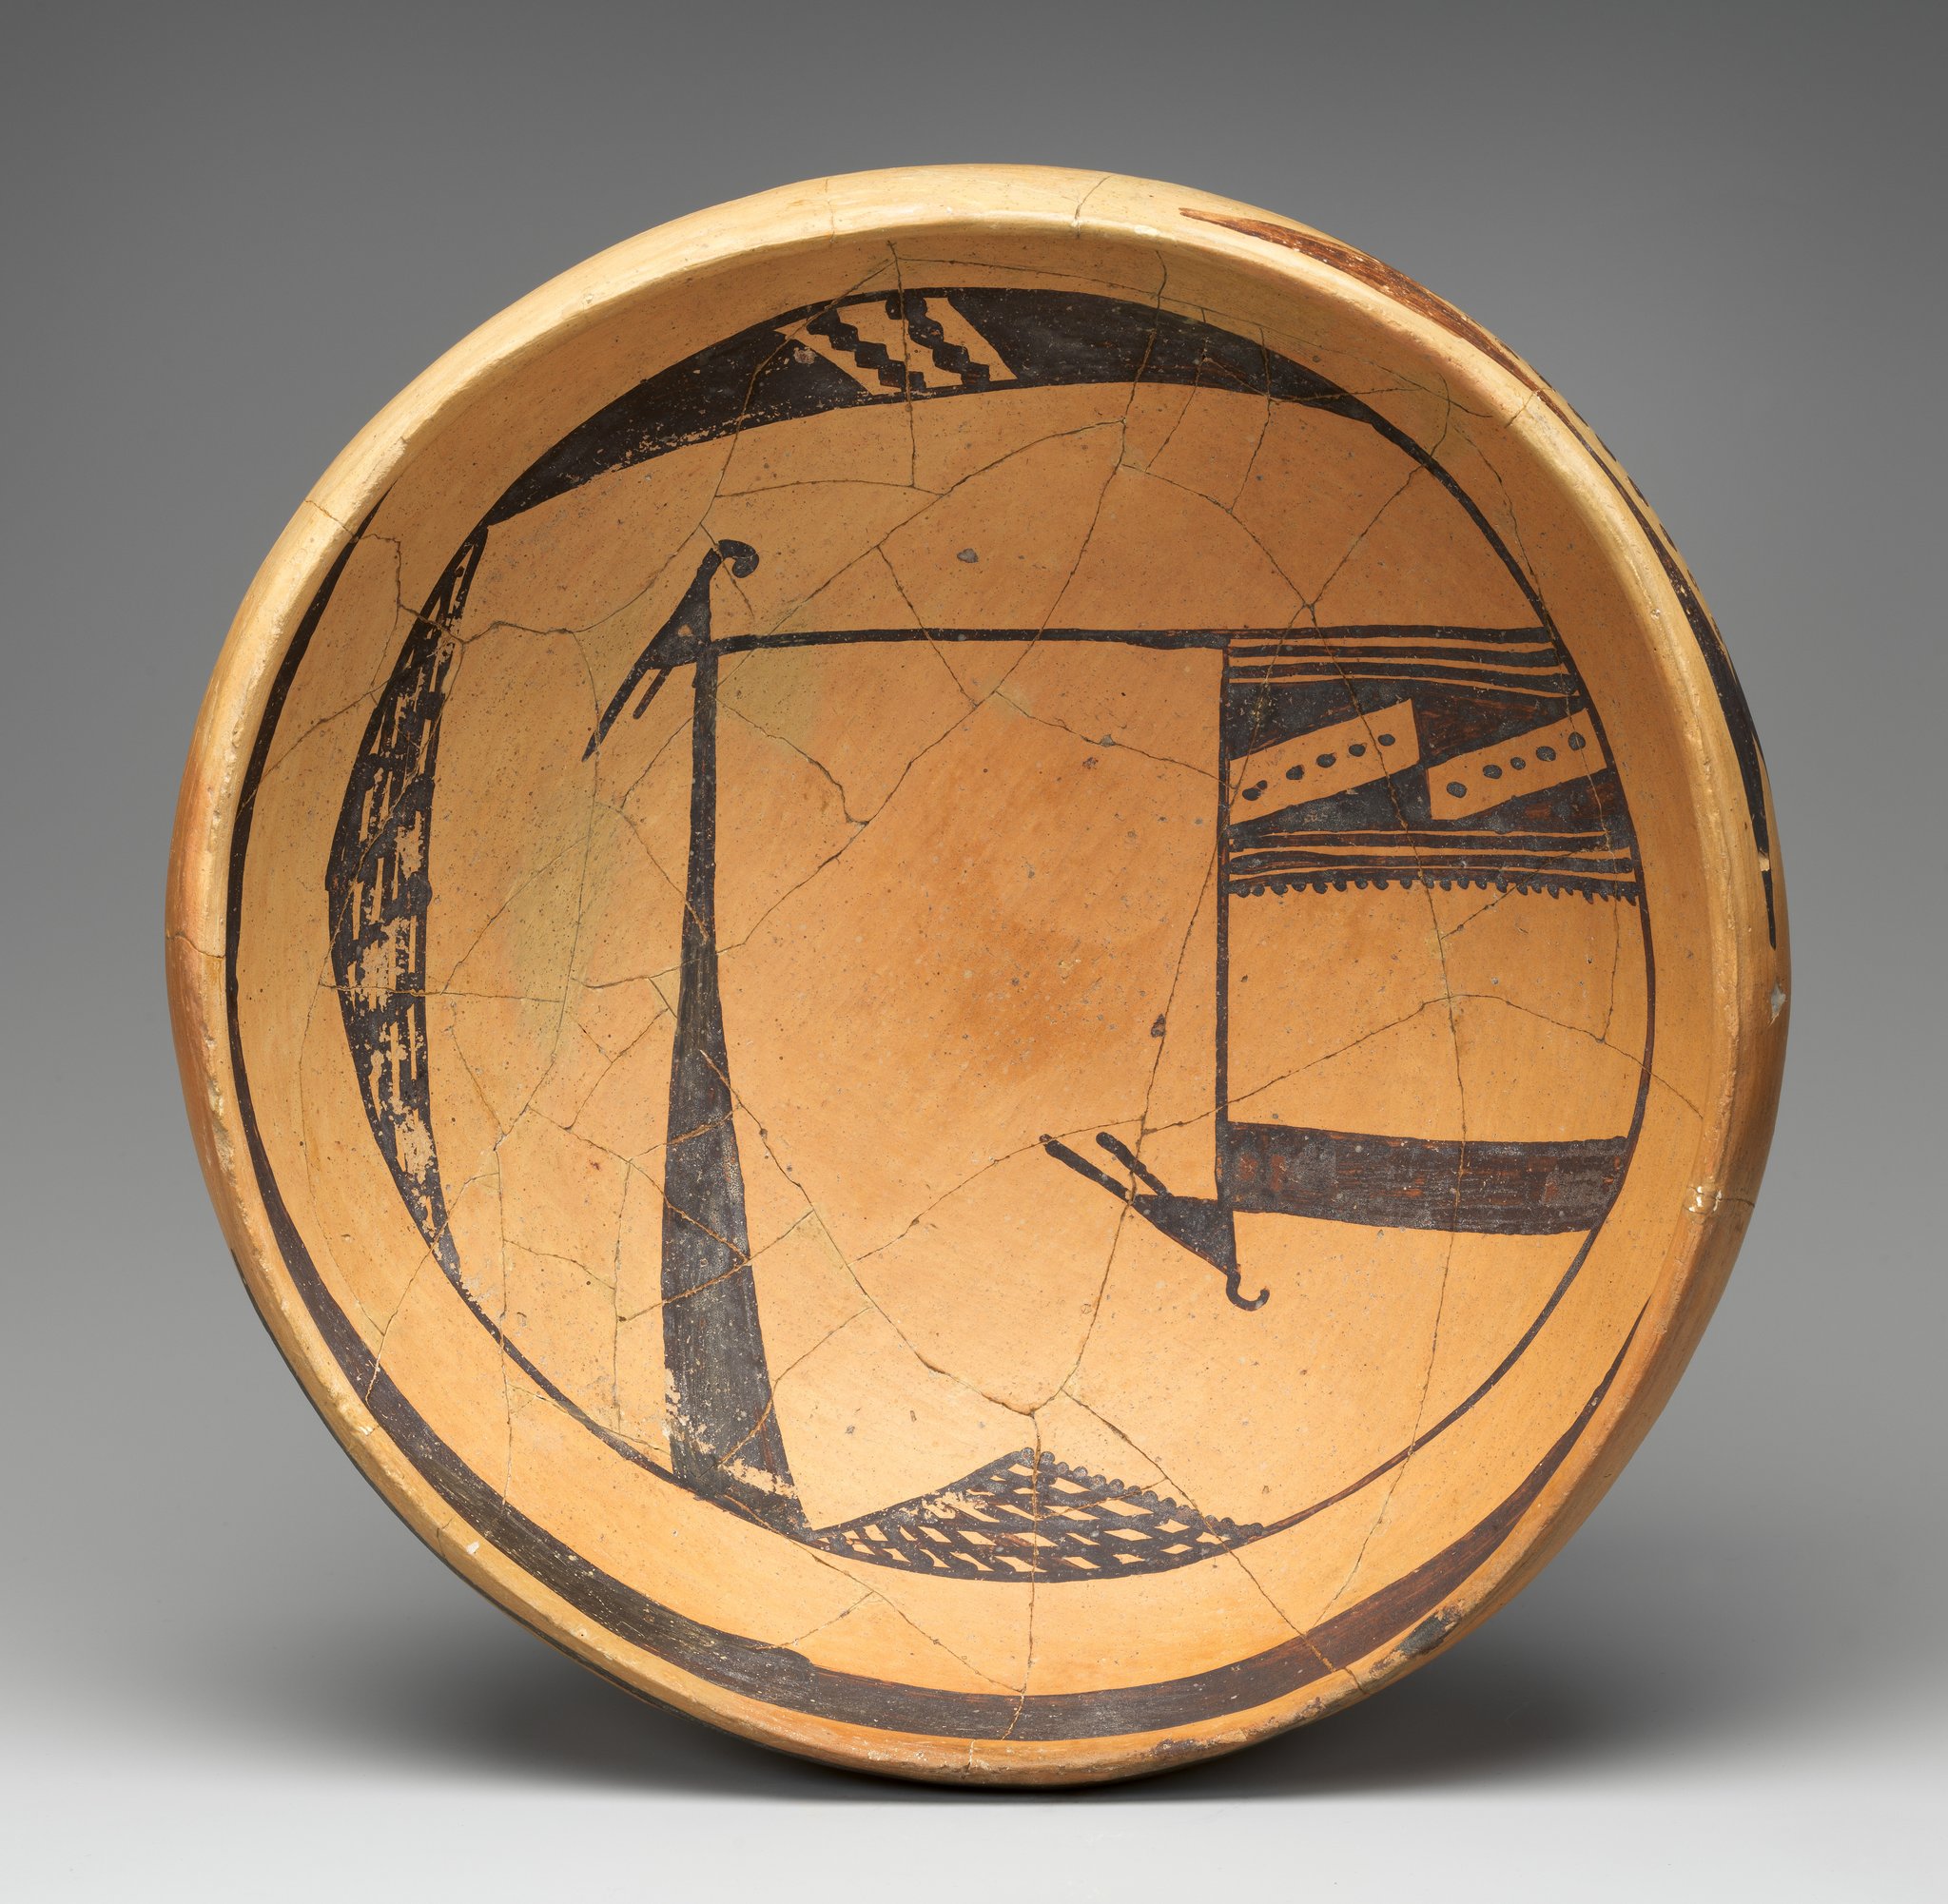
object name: bowl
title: Bowl with Abstract Birds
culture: ancestral puebloan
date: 1301-1400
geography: united states